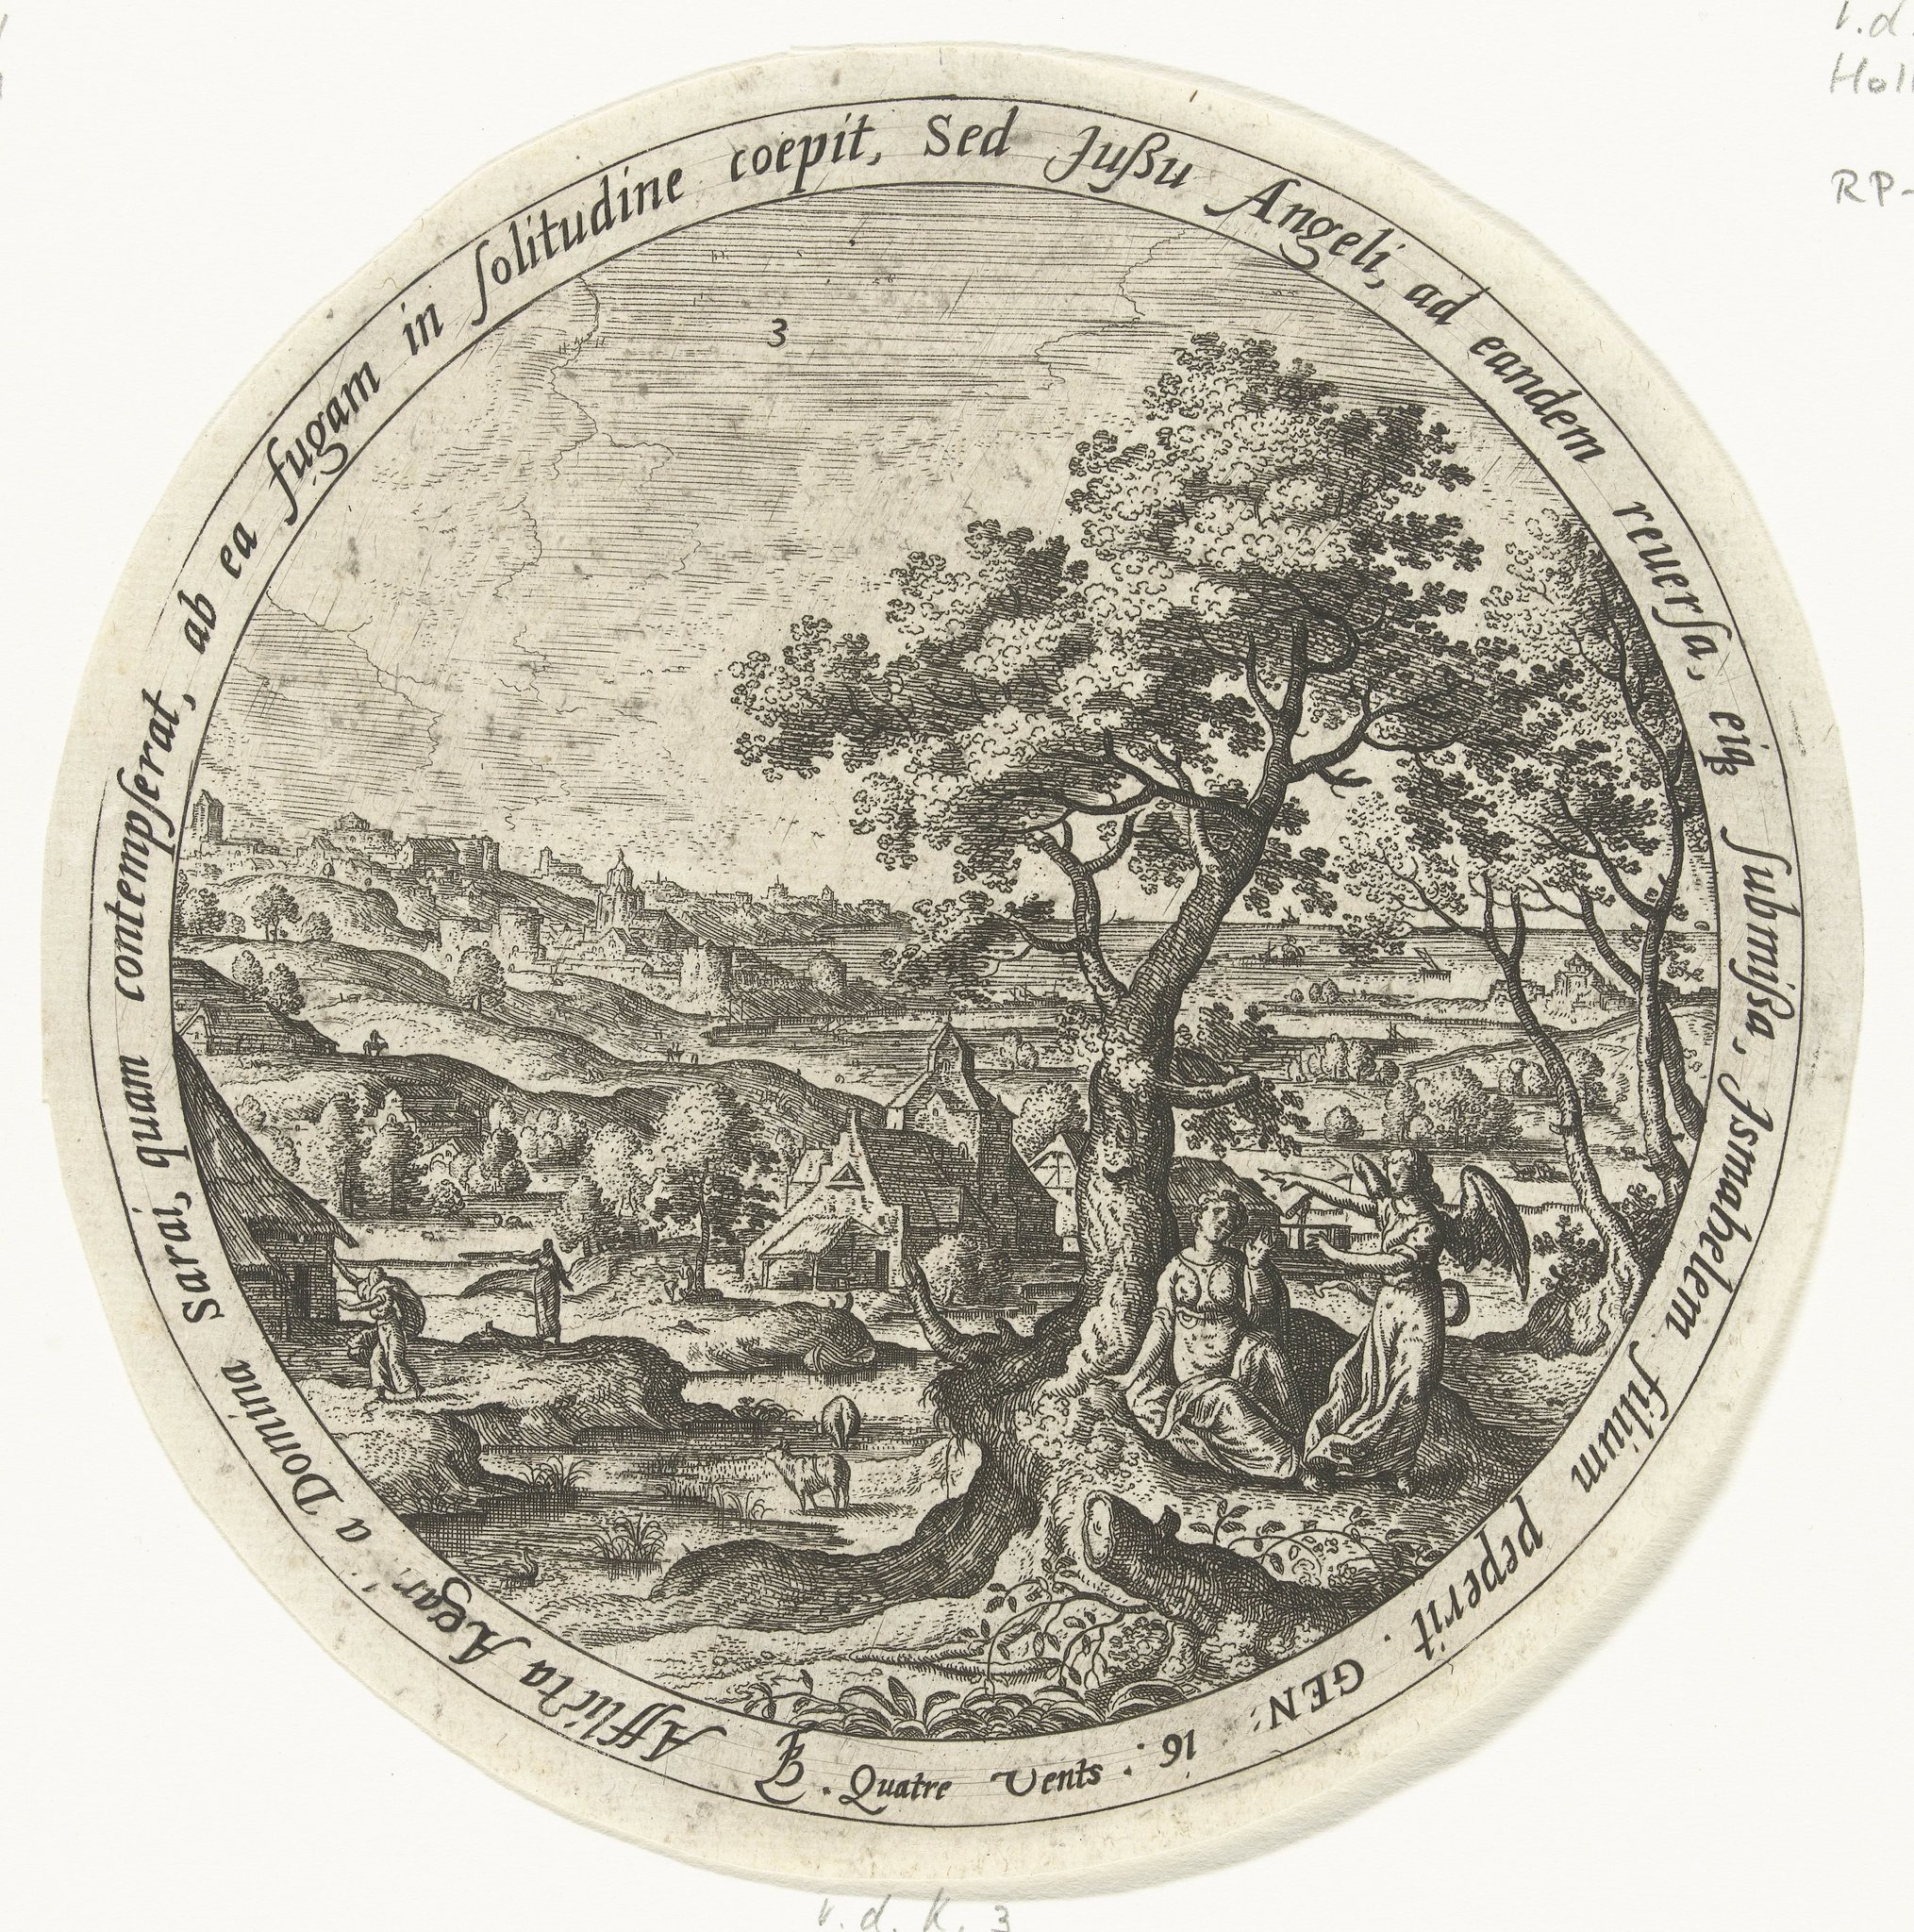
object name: print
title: Hagar en de engel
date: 1560-1570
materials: paper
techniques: etching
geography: antwerp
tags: an angel meets hagar at the fountain on the way to shur and persuades her to return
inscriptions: collector's mark: Lugt 2228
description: Hagar, de dienares van Sara, zit onder een boom bij een rivier. Ze is gevlucht omdat Sara haar het leven zwaar maakt nu dat ze zwanger is van Abraham. Een engel stuurt haar terug naar Abraham en belooft haar dat ze veel nakomelingen zal hebben. Prent uit een serie van zes prenten die het levensverhaal van de aartsvader Abraham verbeelden.